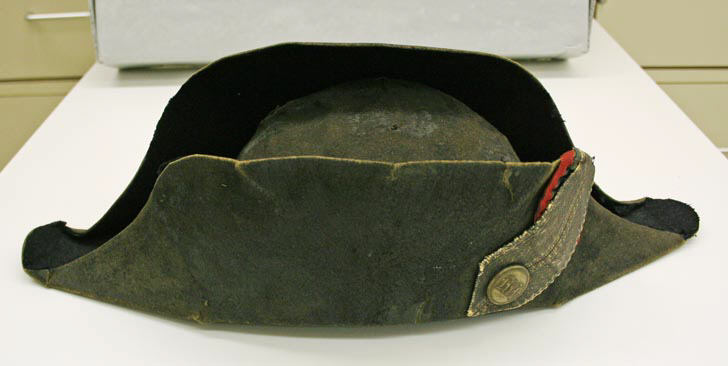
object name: hat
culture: british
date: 1800